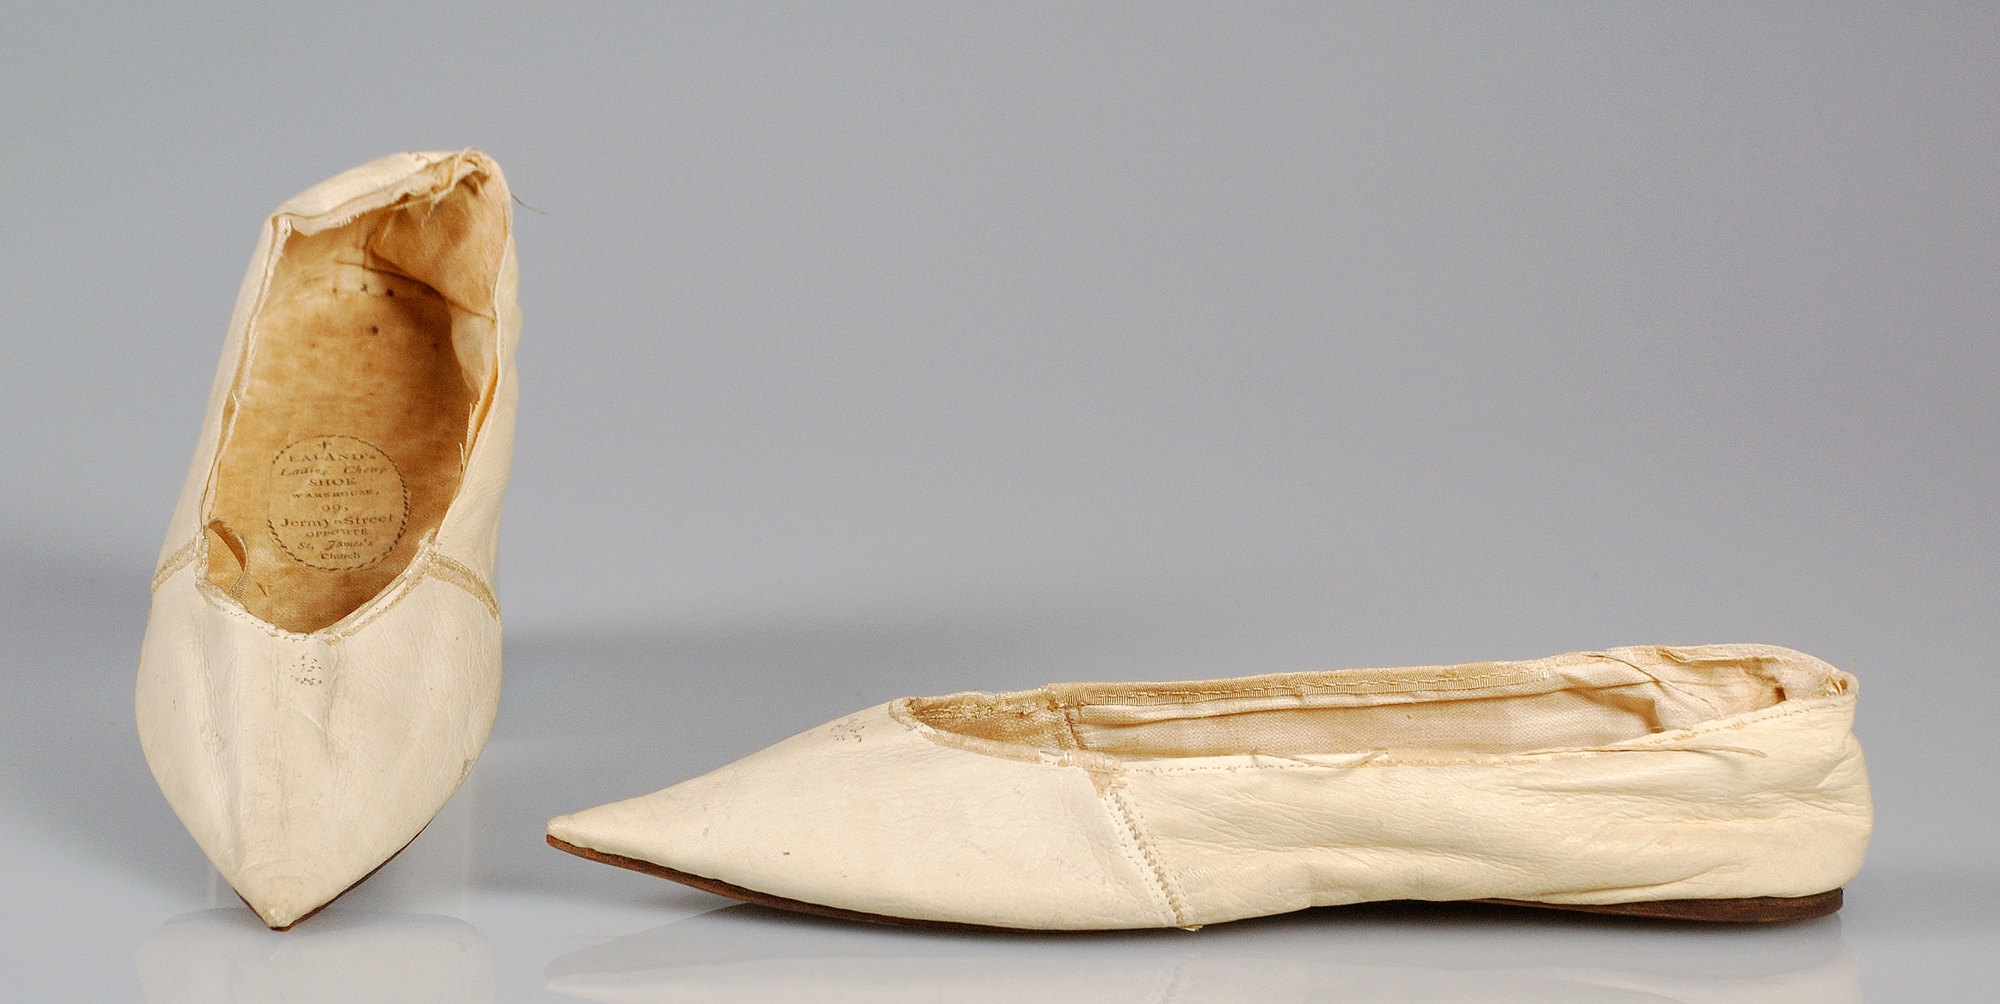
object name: slipper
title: Slippers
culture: british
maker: ealand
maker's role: retailer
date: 1800-1810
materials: leather